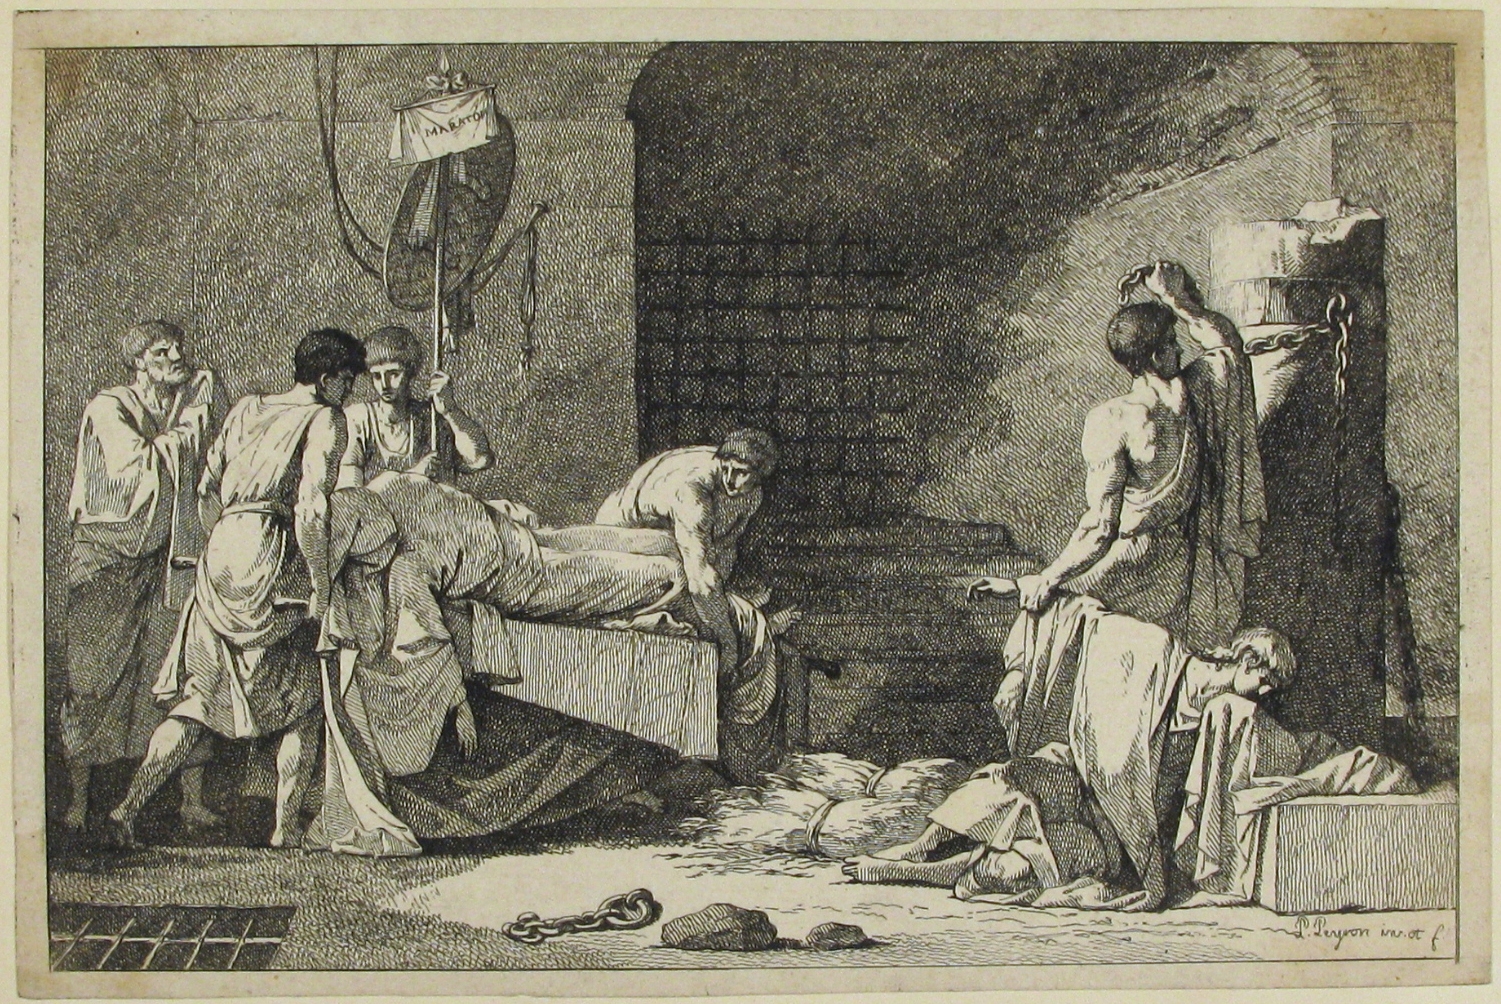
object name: print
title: Les funérailles de Miltiade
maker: pierre peyron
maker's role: artist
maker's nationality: french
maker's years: 1744-1814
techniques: etching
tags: men,death